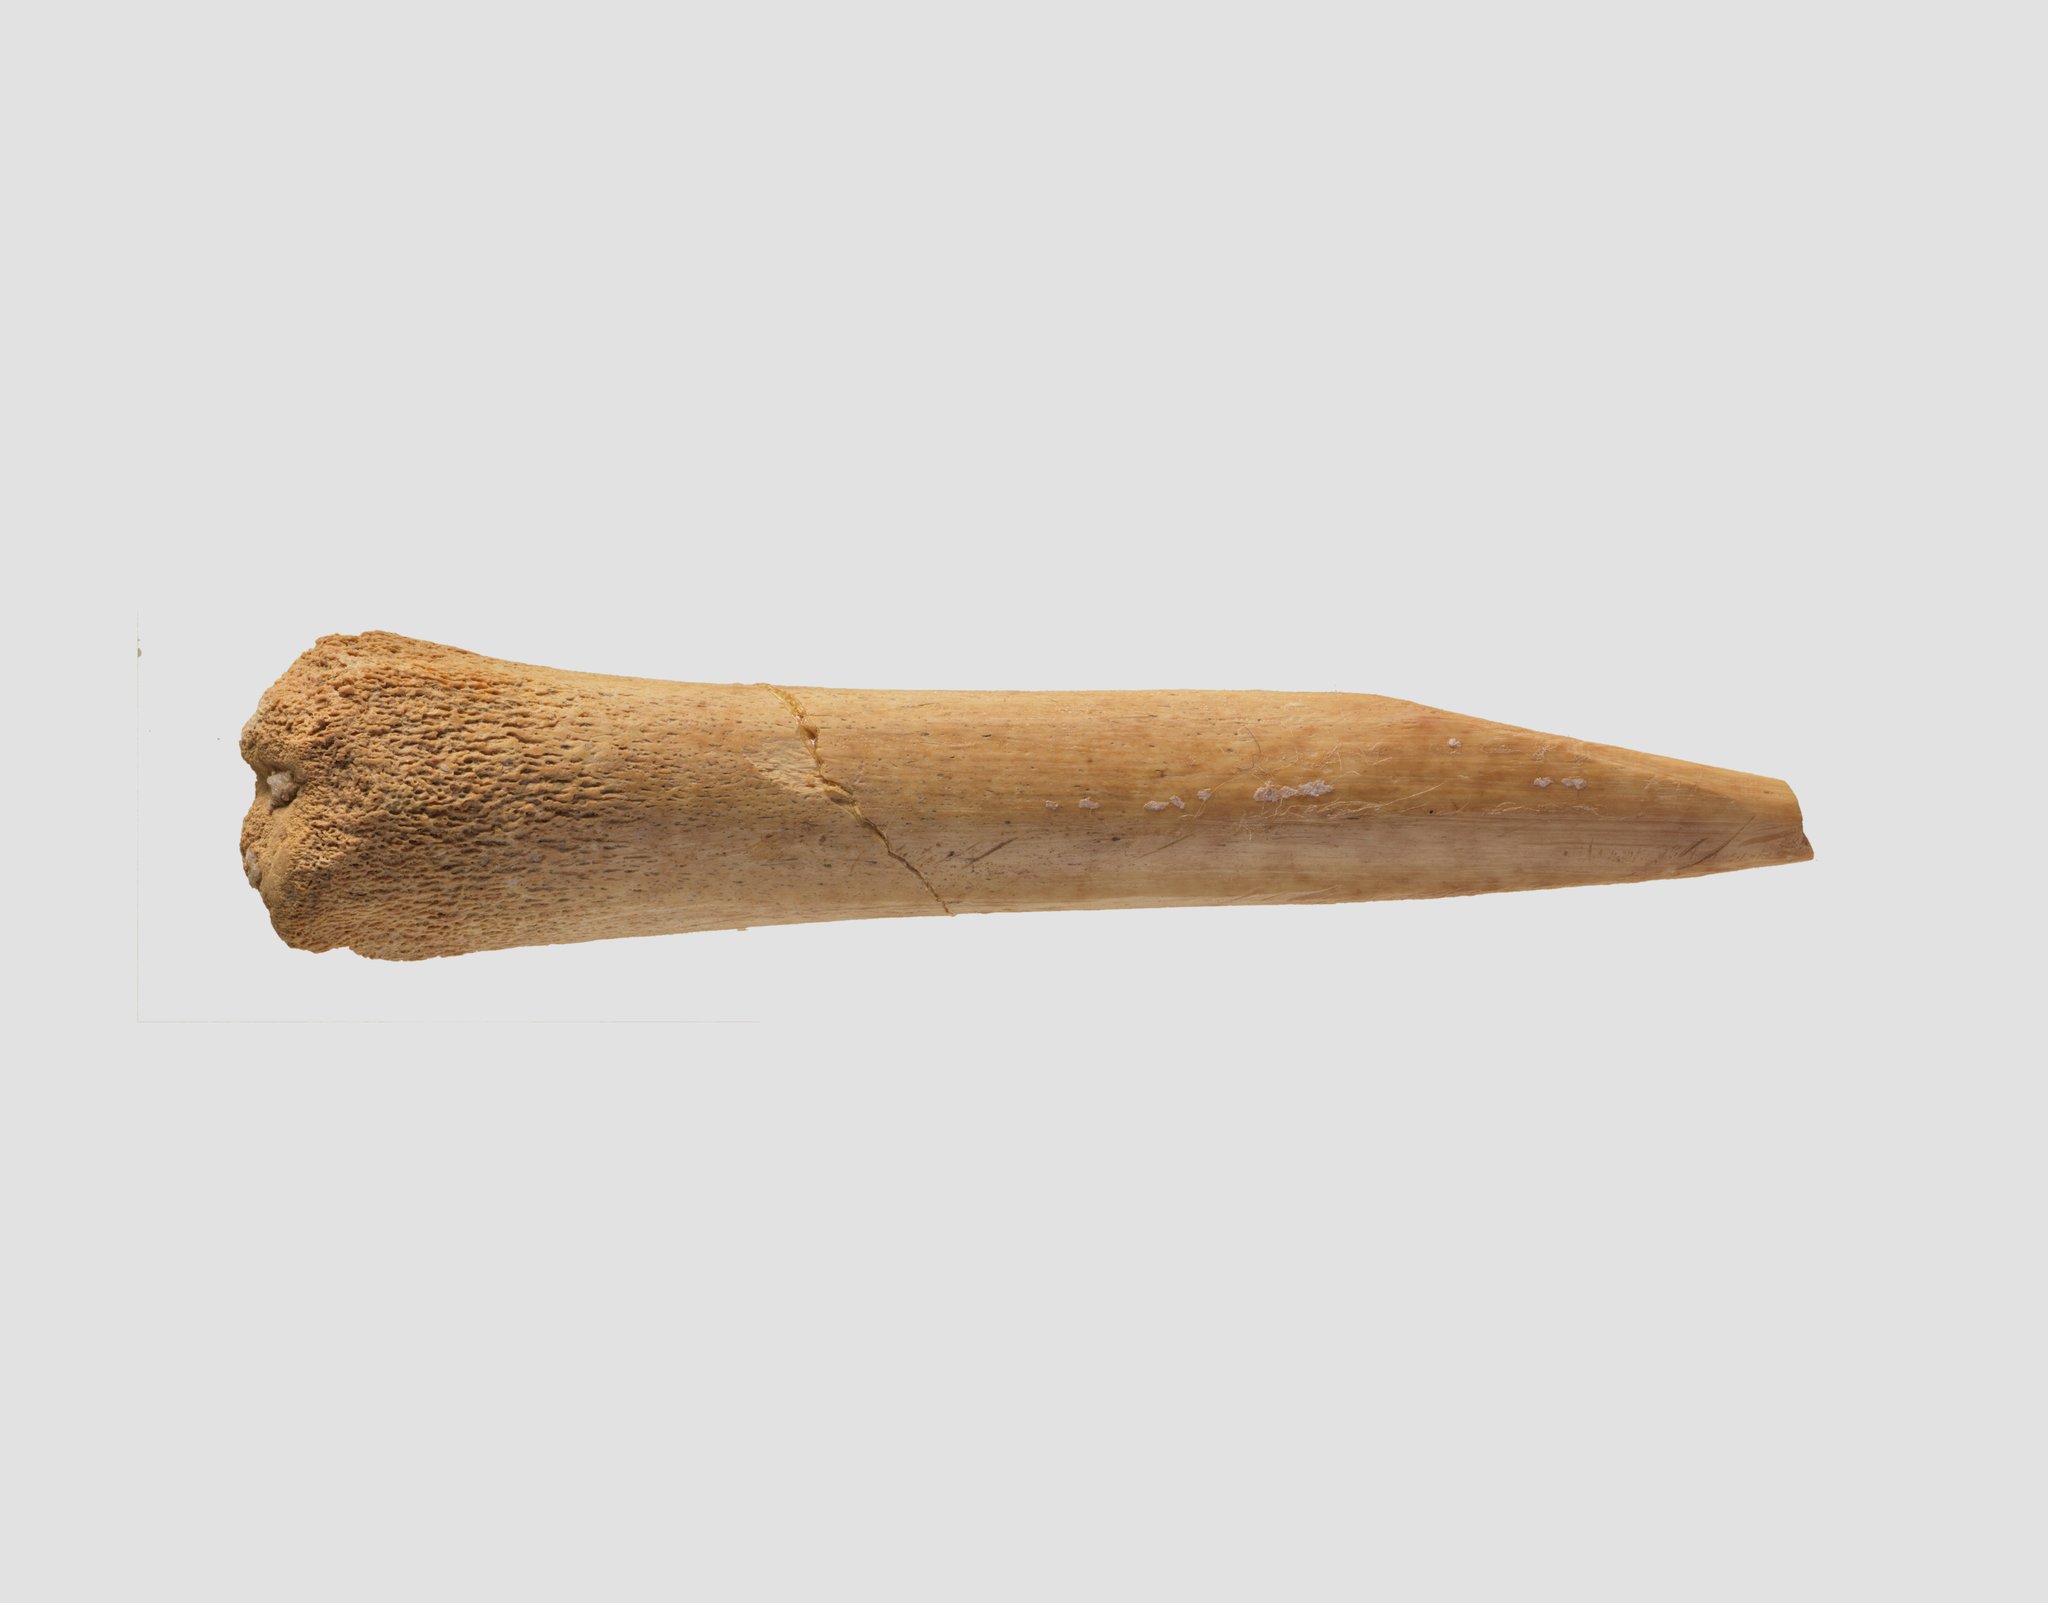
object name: awl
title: Awl (?)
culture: ghassulian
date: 4600-3600 BCE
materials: bone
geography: levant